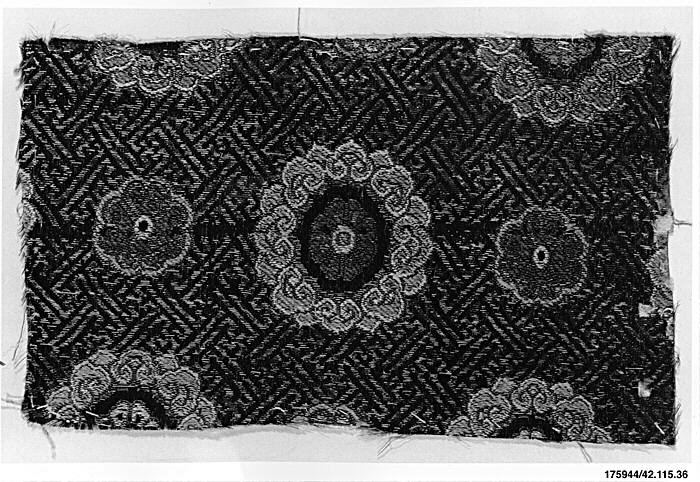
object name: piece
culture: chinese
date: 1701-1733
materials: metal thread, silk